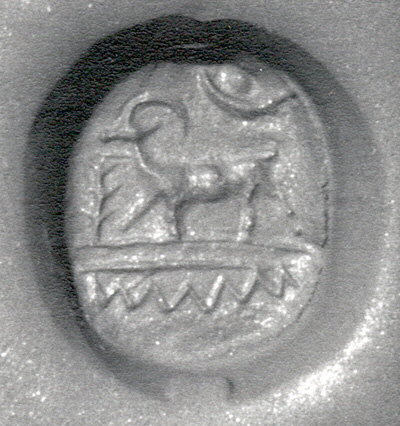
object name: stamp seal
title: Stamp seal (scaraboid) with animal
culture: neo-assyrian or syro-anatolian-levantine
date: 900-601 BCE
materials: stone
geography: levant or syria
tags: animals